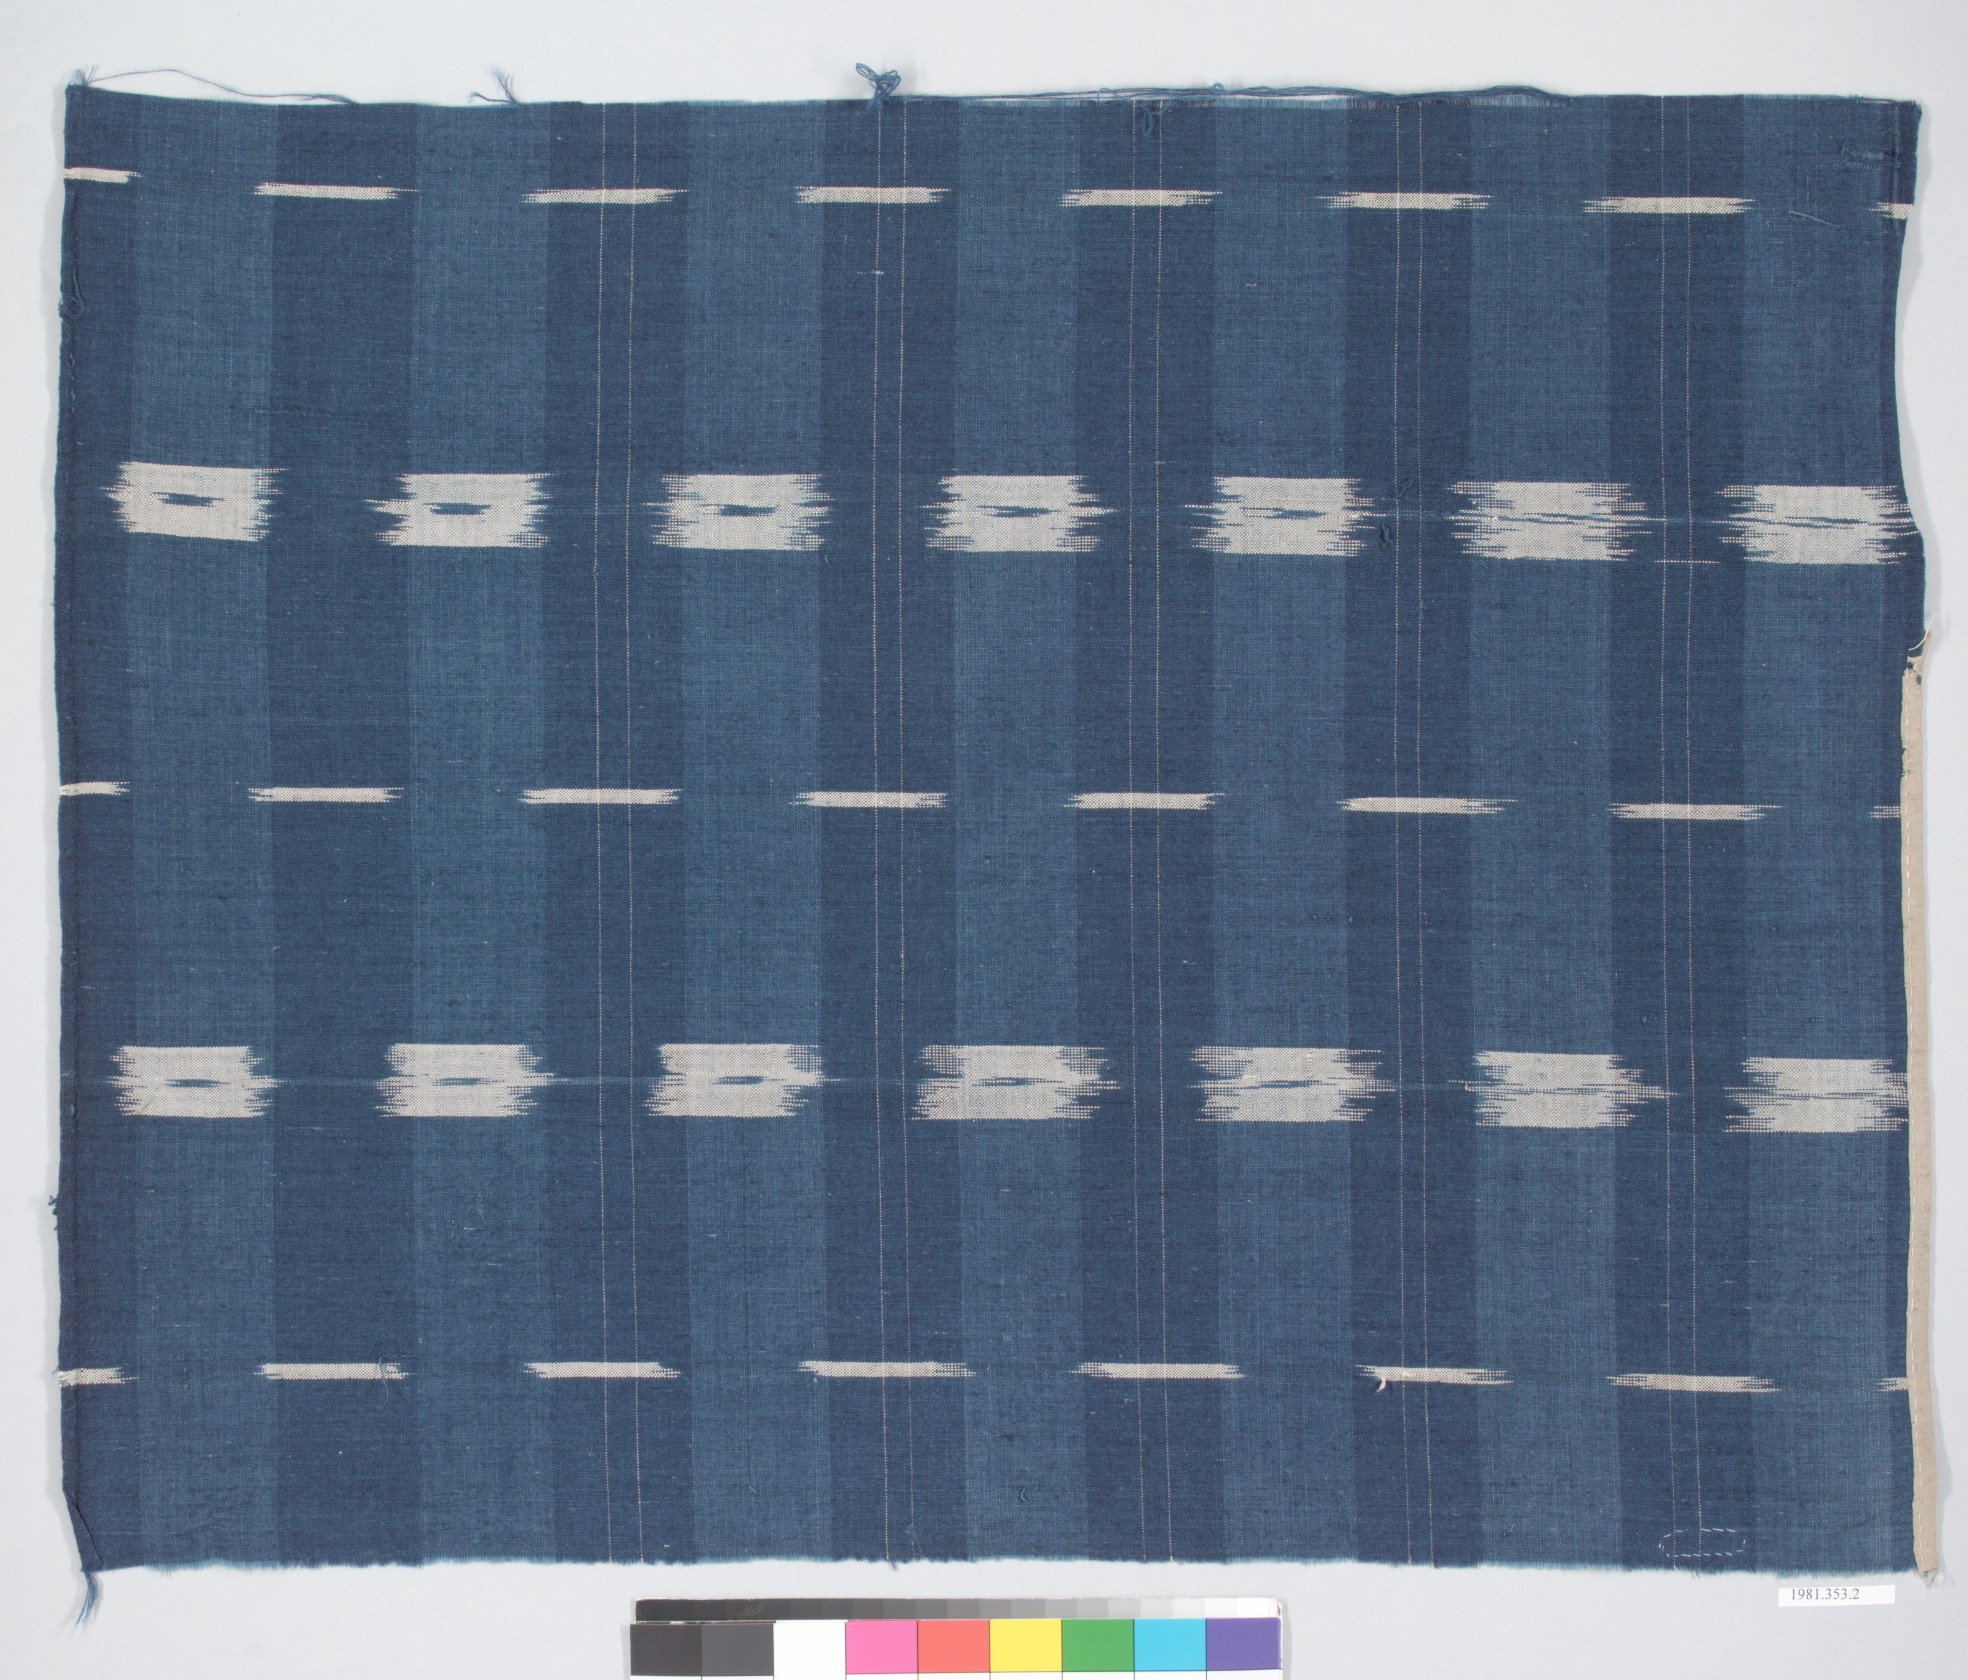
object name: piece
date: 1701-1800